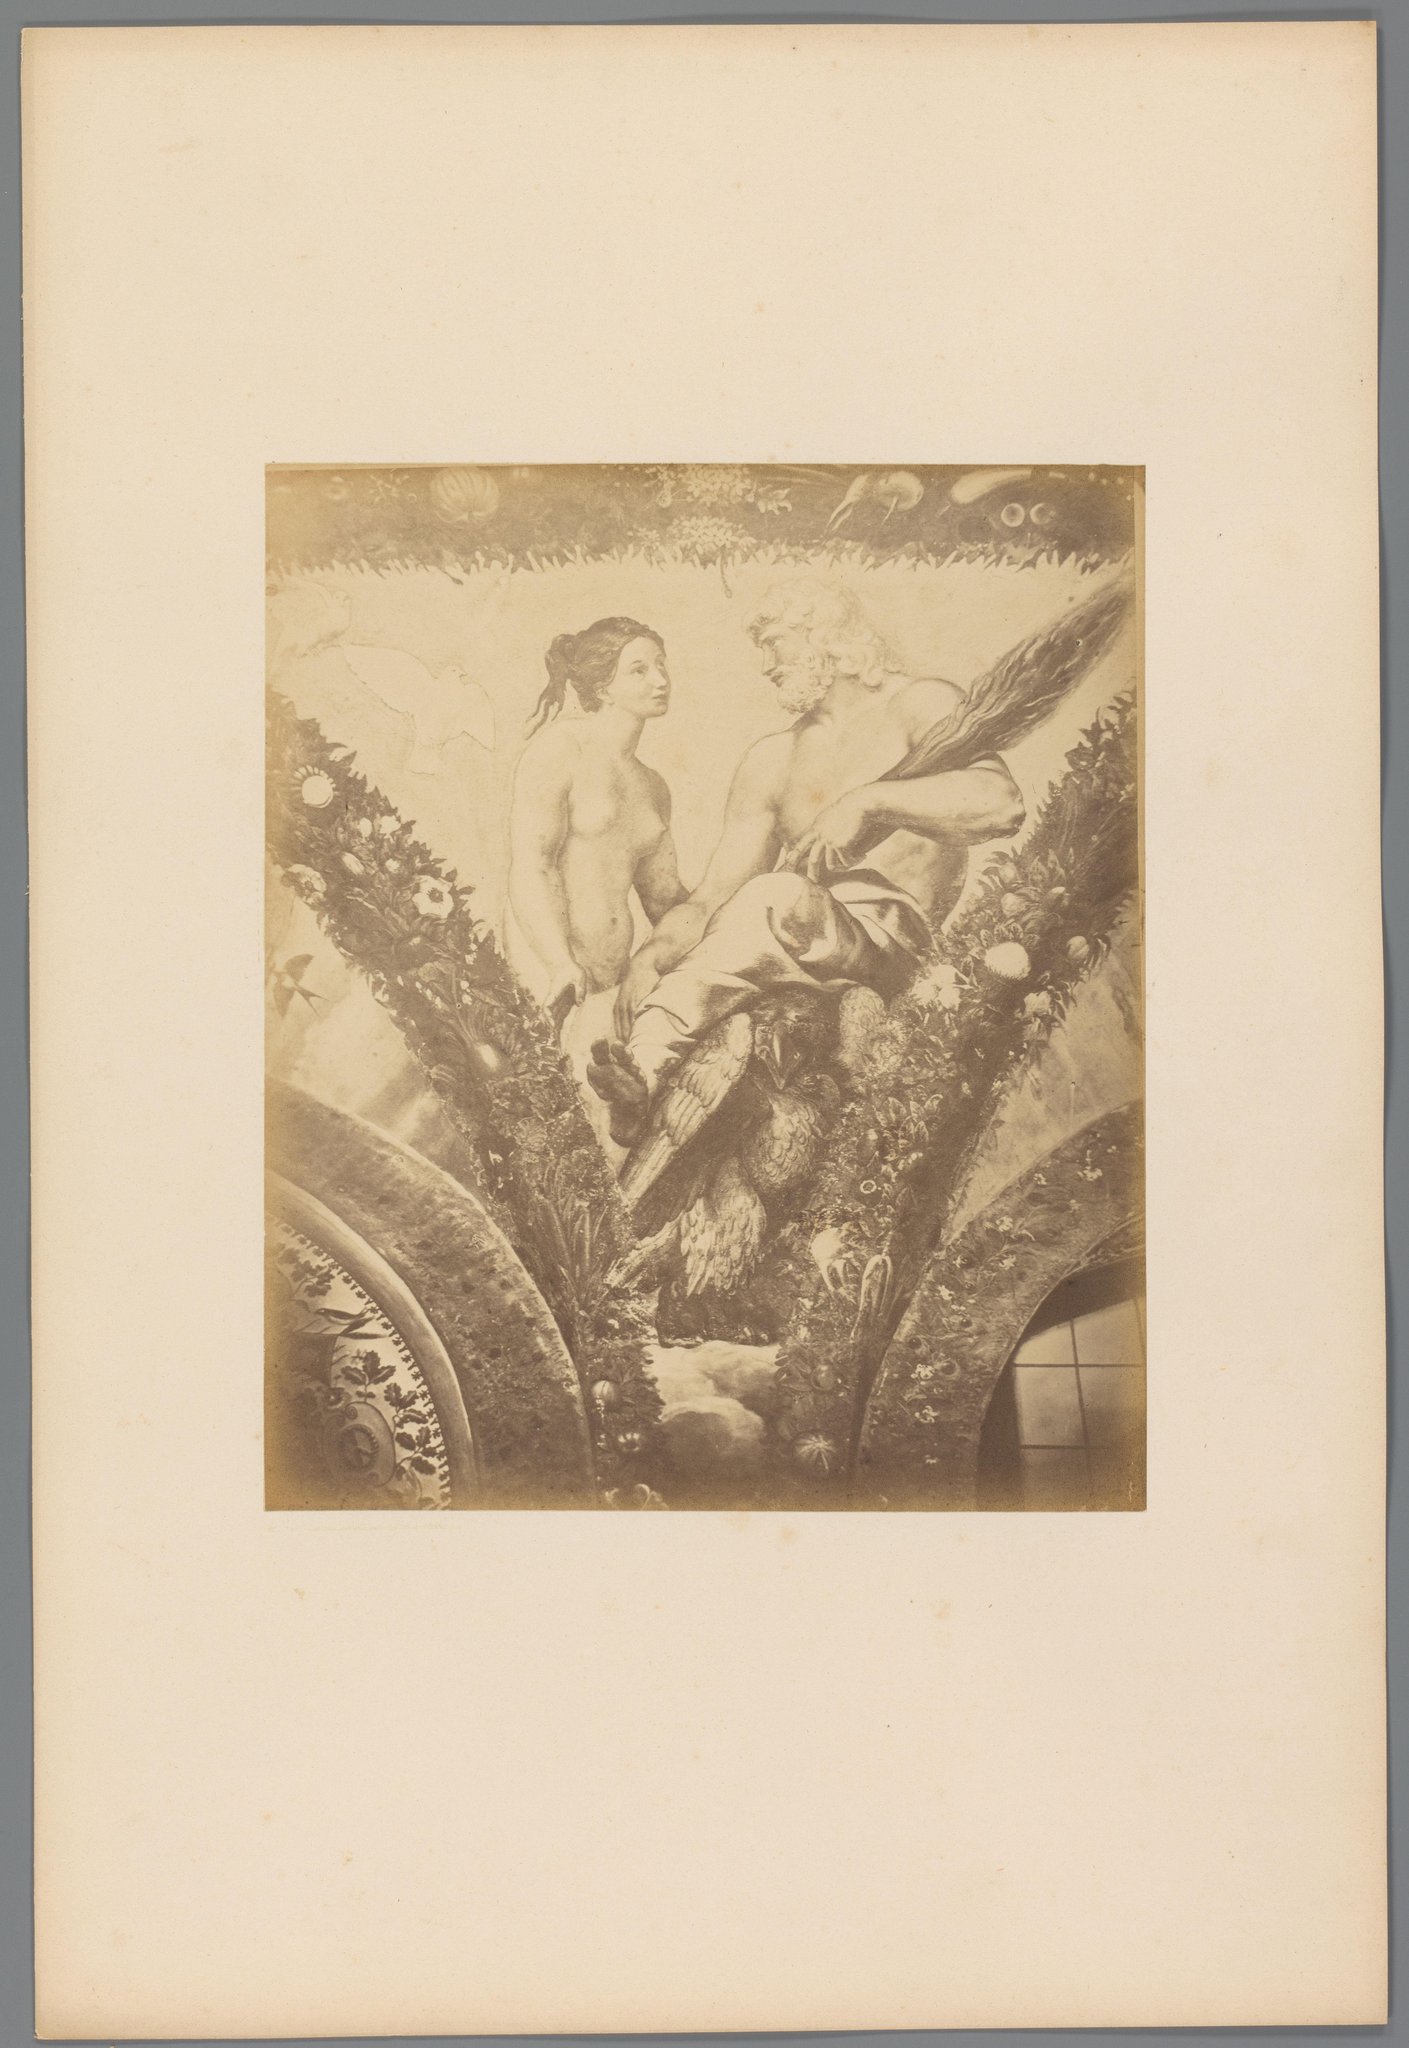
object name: photograph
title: Fotoreproductie van een fresco van Venus en Jupiter naar Rafaël in de loggia van de Villa Farnesina te Rome, Italië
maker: Anonymous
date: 1851-1900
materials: cardboard, paper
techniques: albumen print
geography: rome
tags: wall-covering